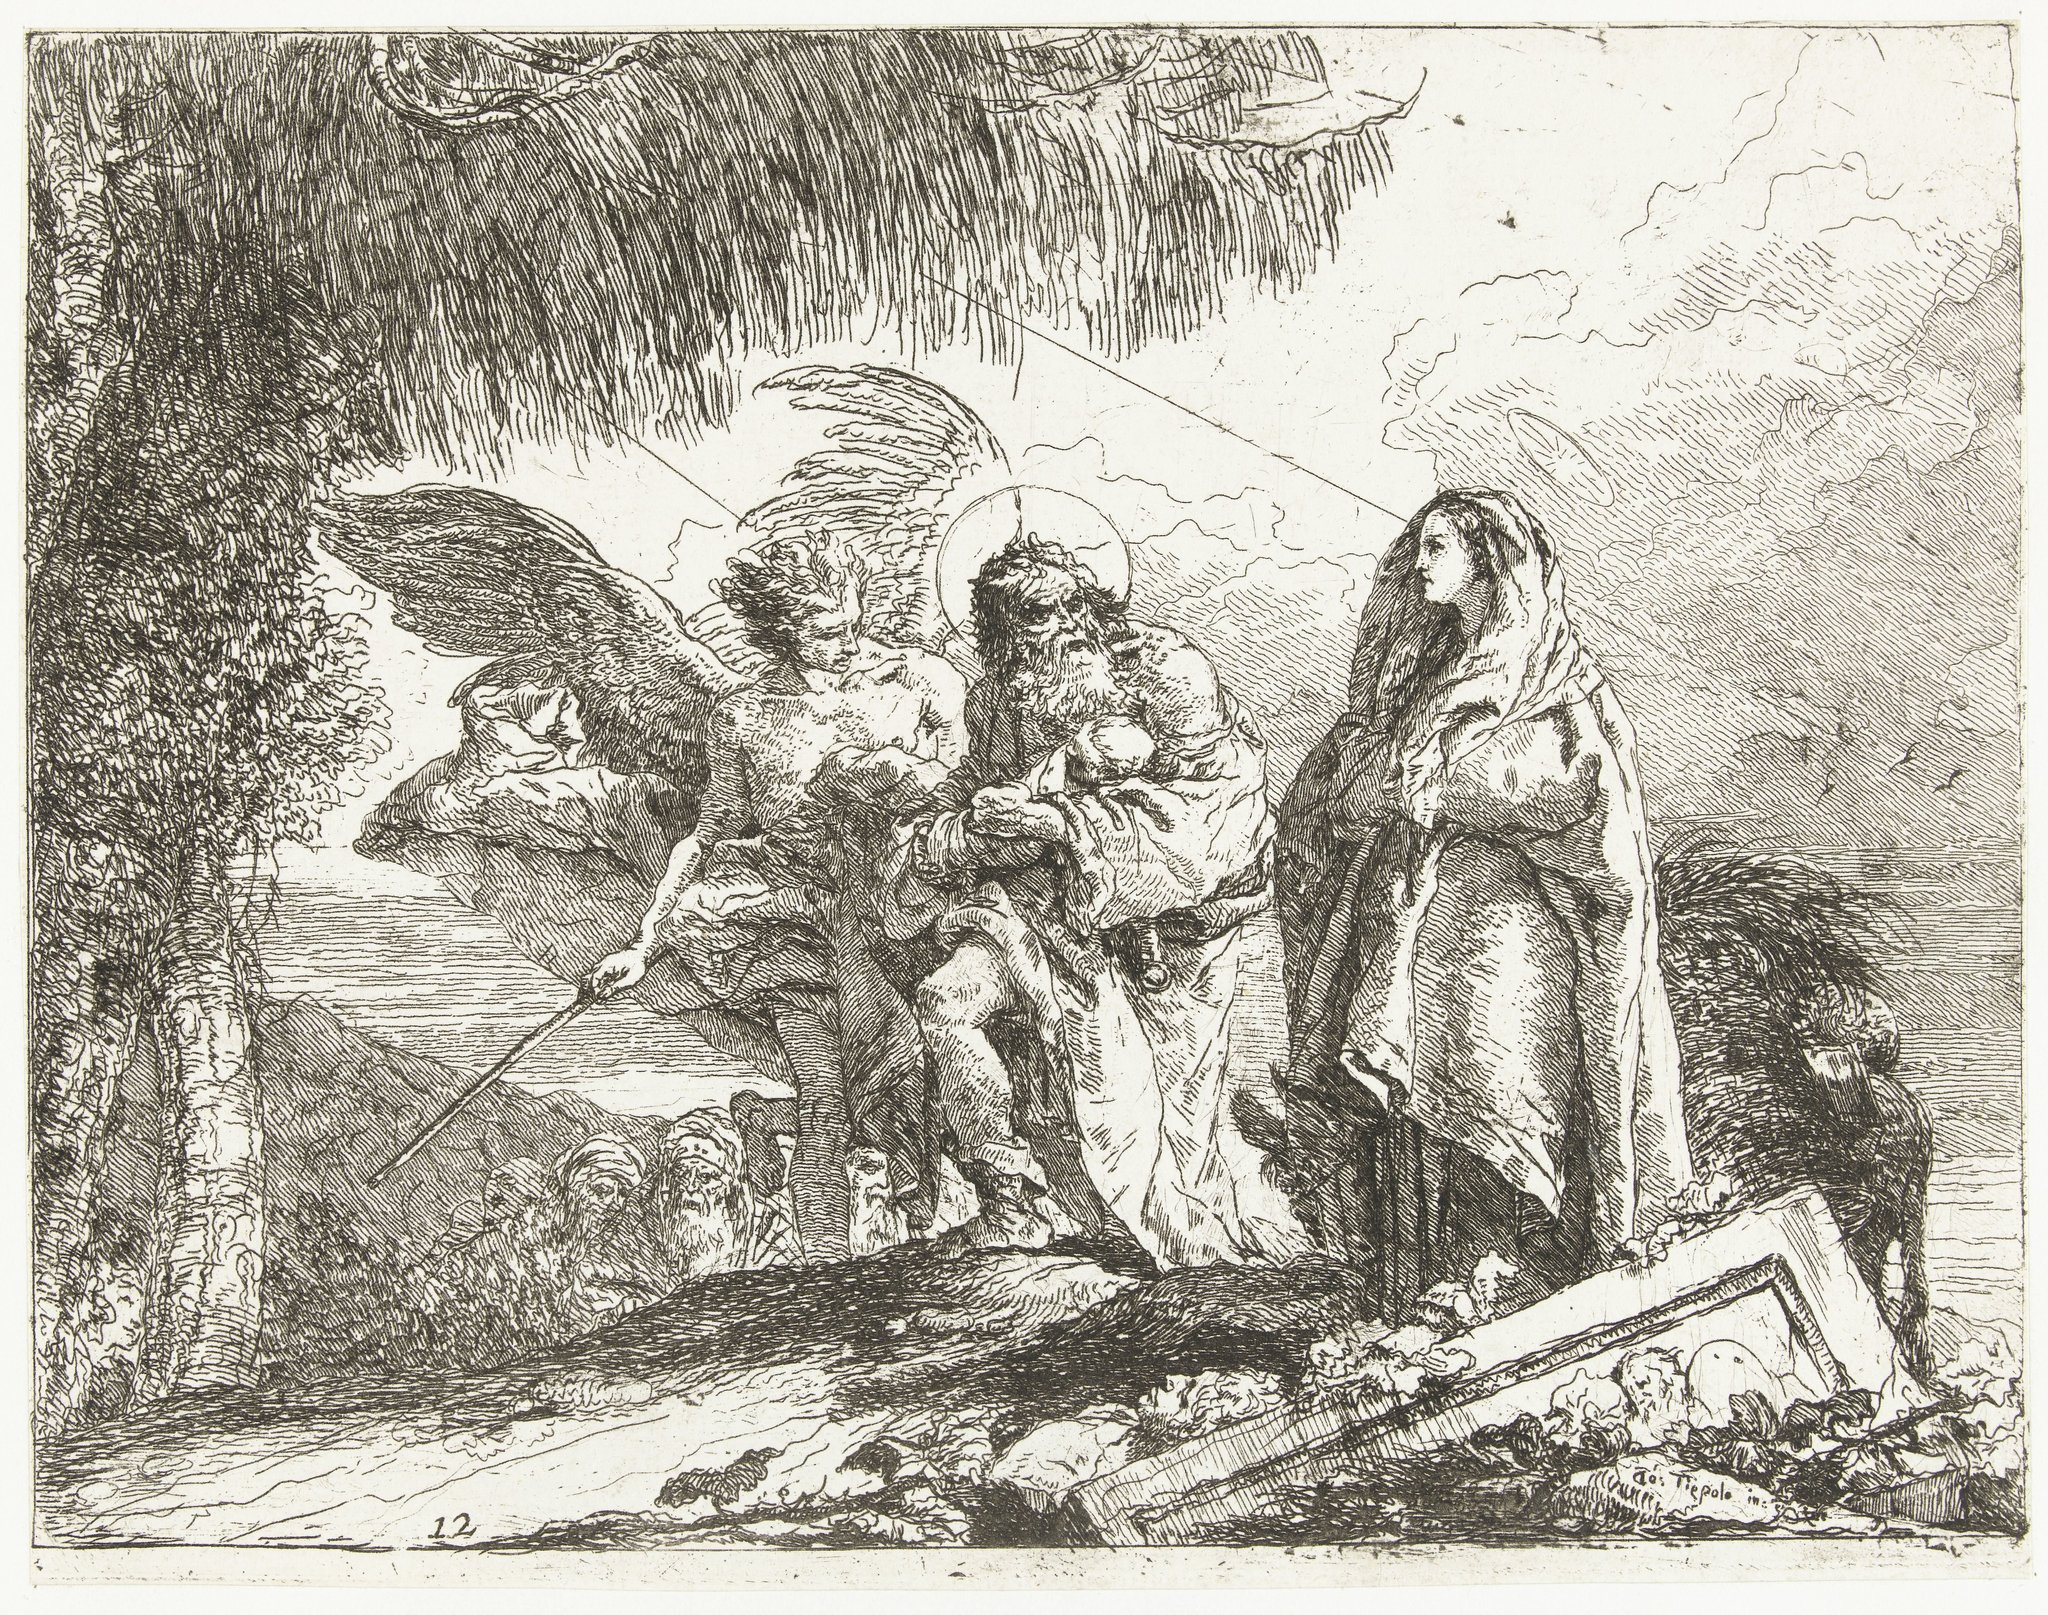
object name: print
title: Jozef met Kind in armen en Maria lopen met engel tijdens vlucht naar Egypte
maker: giovanni domenico tiepolo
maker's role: draughtsman, print maker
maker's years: 1727-1804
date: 1750-1753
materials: paper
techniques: etching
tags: flight into egypt and miracles during the journey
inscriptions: collector's mark: Lugt 2228, collector's mark: Lugt 2760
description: Prent uit serie van zevenentwintig prenten met de Vlucht naar Egypte.